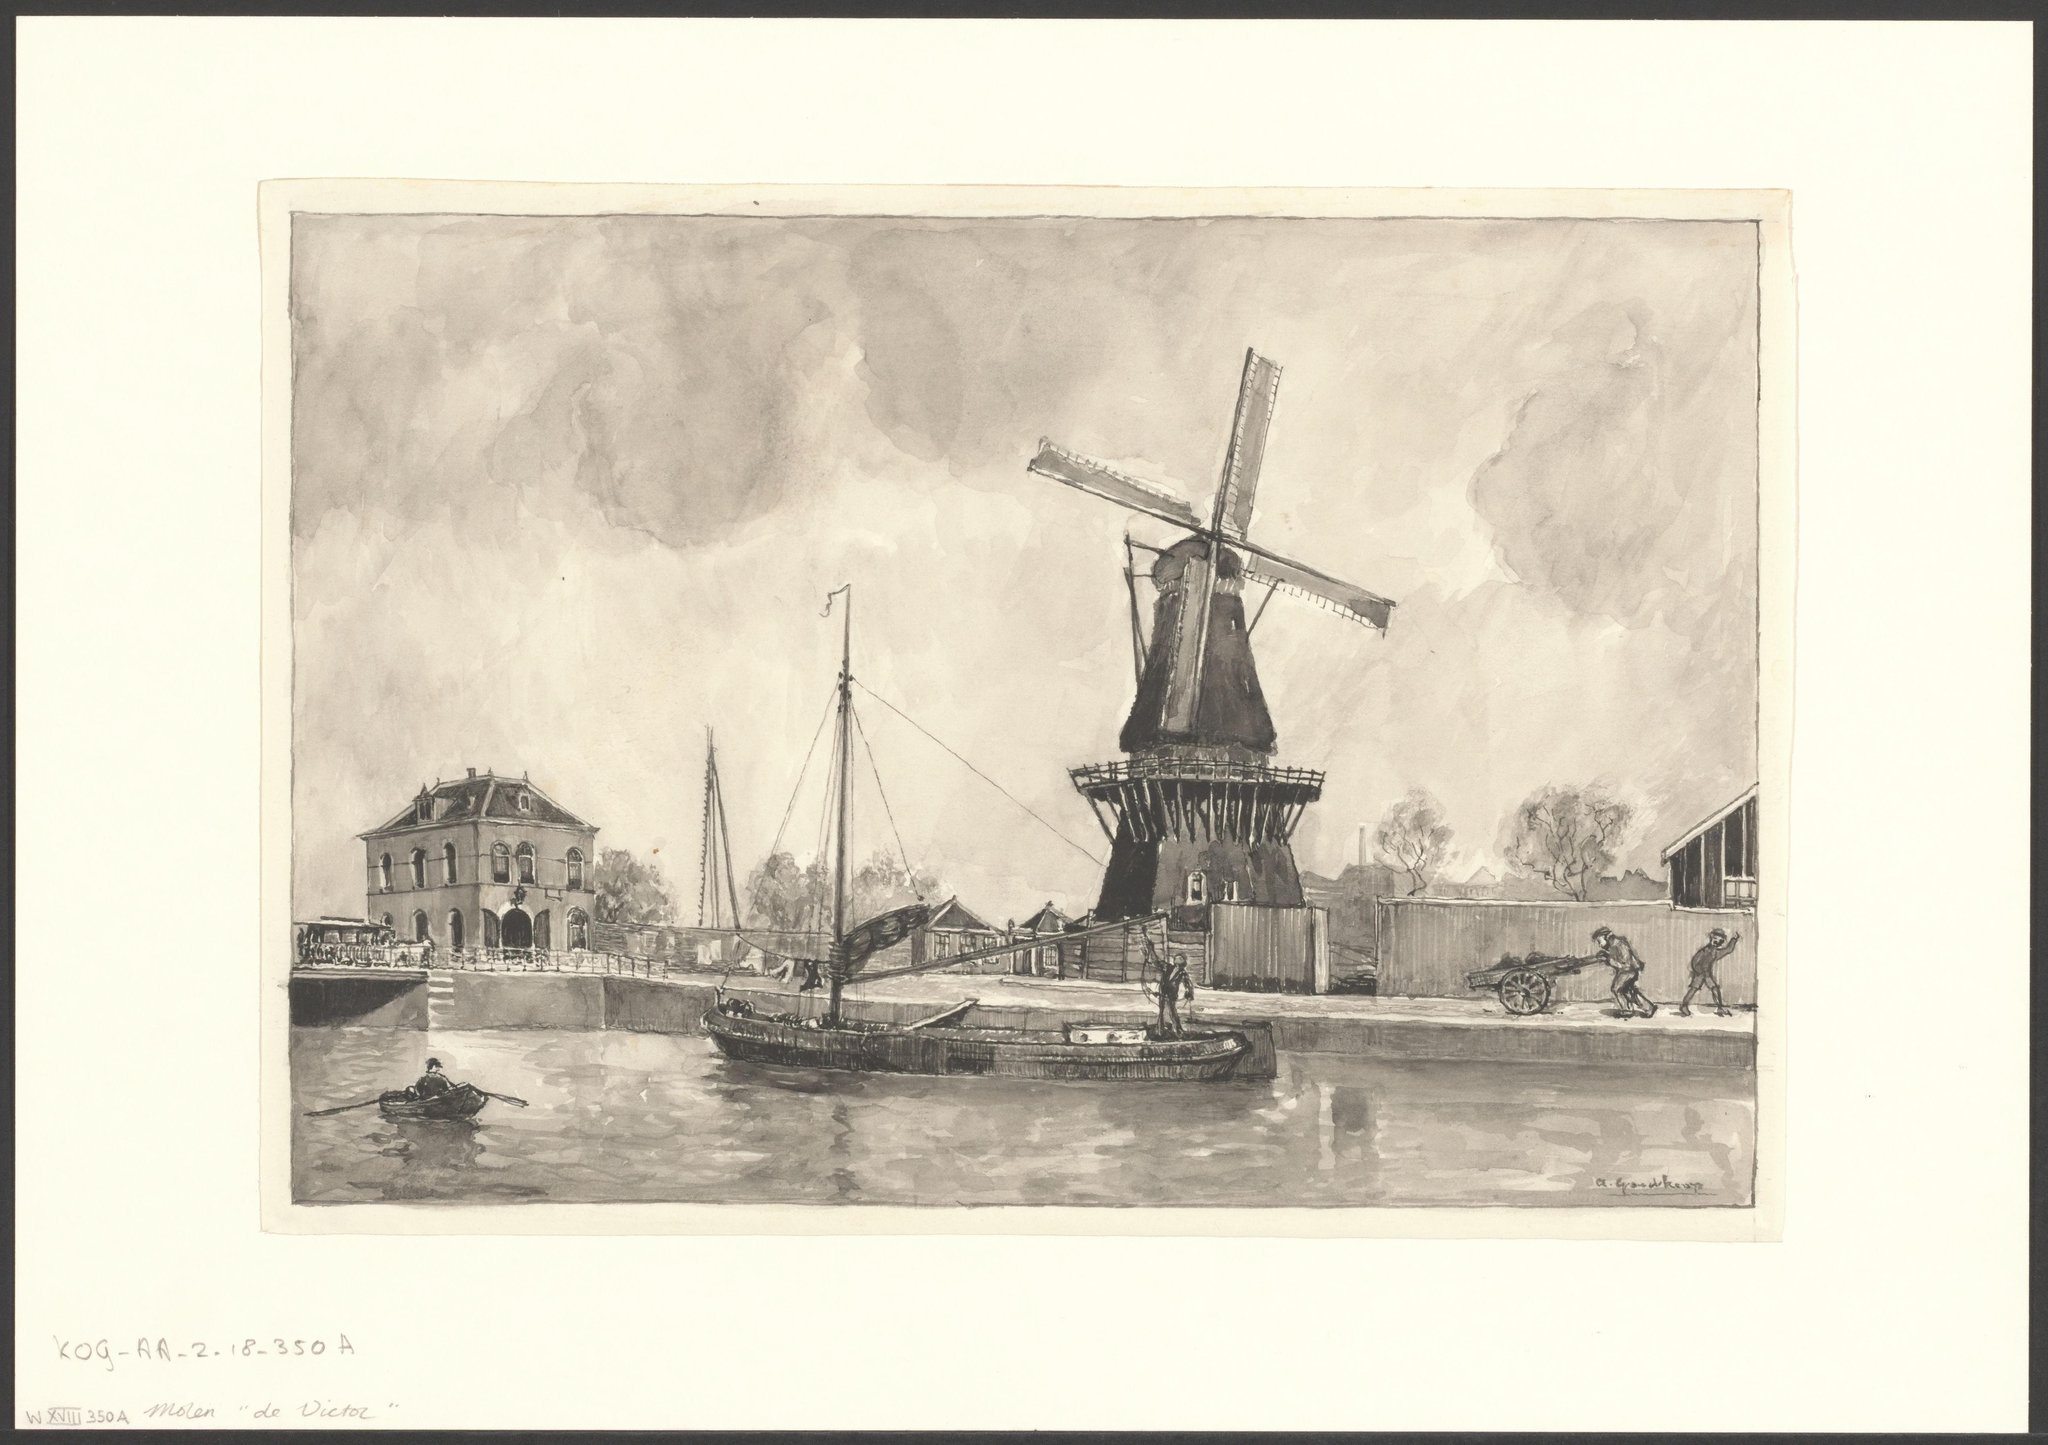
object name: drawing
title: Gezicht op de Singelgracht gezien naar de brug voor de Rozengracht en molen De Victor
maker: goedkoop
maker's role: draughtsman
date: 1850-1950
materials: ink, paper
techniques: brush, pen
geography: amsterdam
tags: city-view in general; 'veduta', canal, windmill in landscape, bridge in city across river, canal, etc.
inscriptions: signature: ‘a. goedkoop’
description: Tekening binnen de Atlas Van Eck ingedeeld op wijknummer 18.